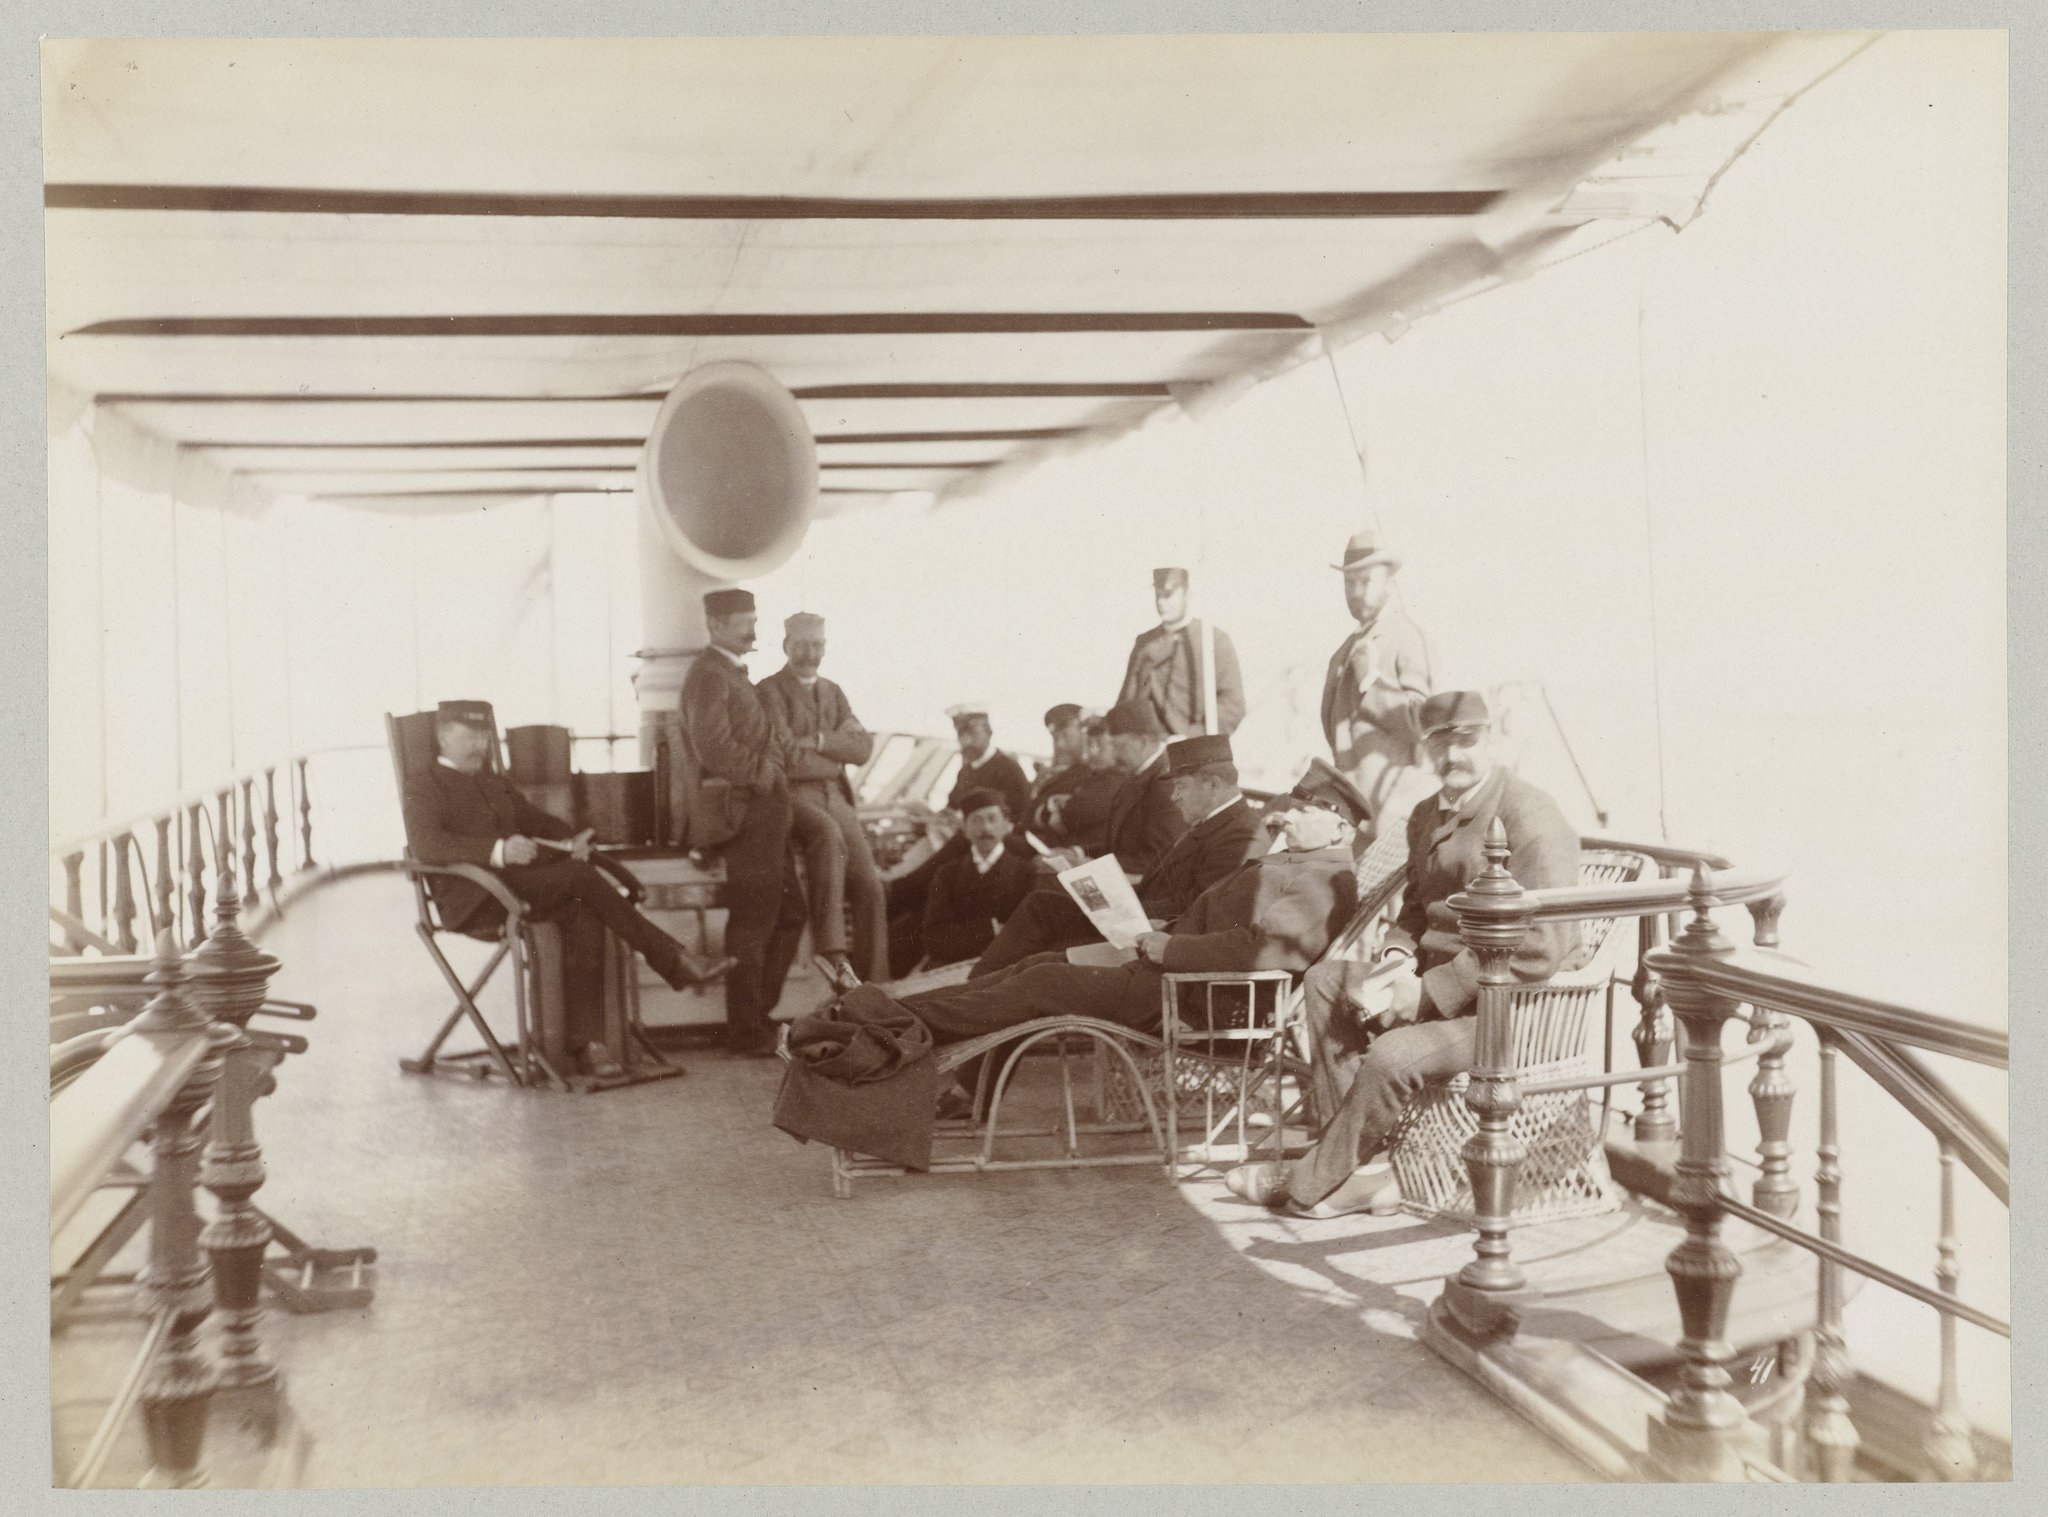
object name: photograph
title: Gezelschap met Keizer Wilhelm II aan boord van de Hohenzollern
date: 1807-1889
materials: cardboard, paper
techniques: albumen print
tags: wilhelm ii (keizer van duitsland), norway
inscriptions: number: ‘16’, number: ‘41’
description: De afdruk van de foto is rond, het papier vierkant